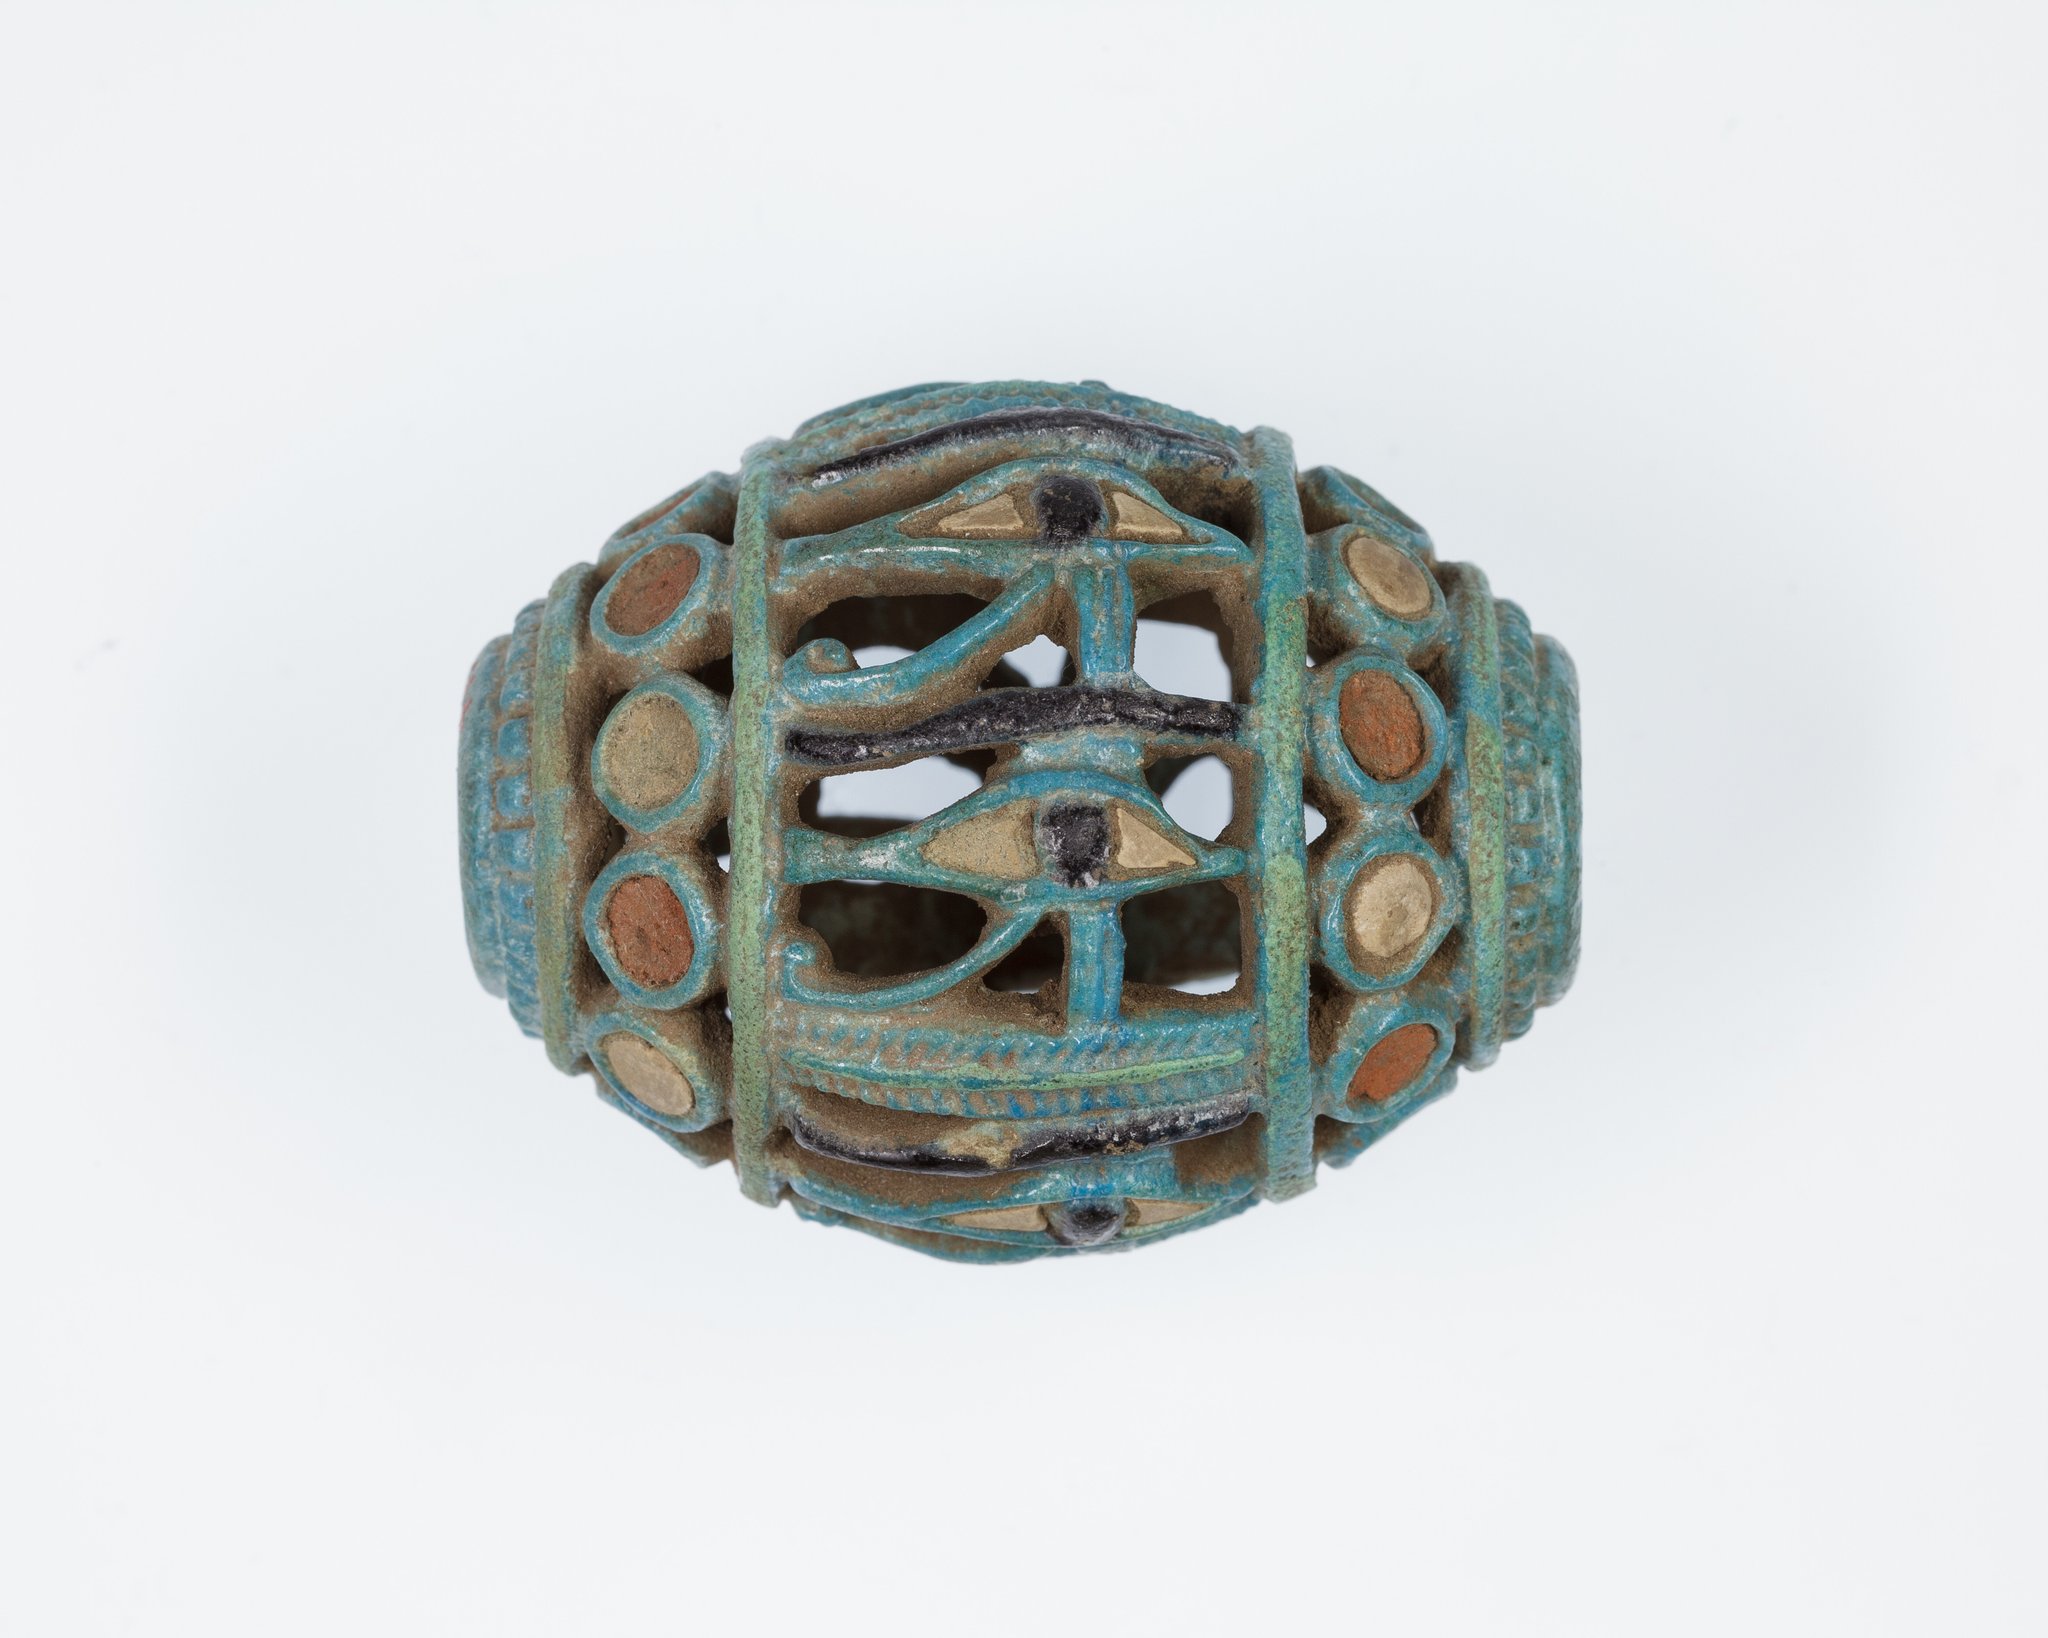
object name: bead, openwork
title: Openwork bead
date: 664-630 BCE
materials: faience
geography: egypt